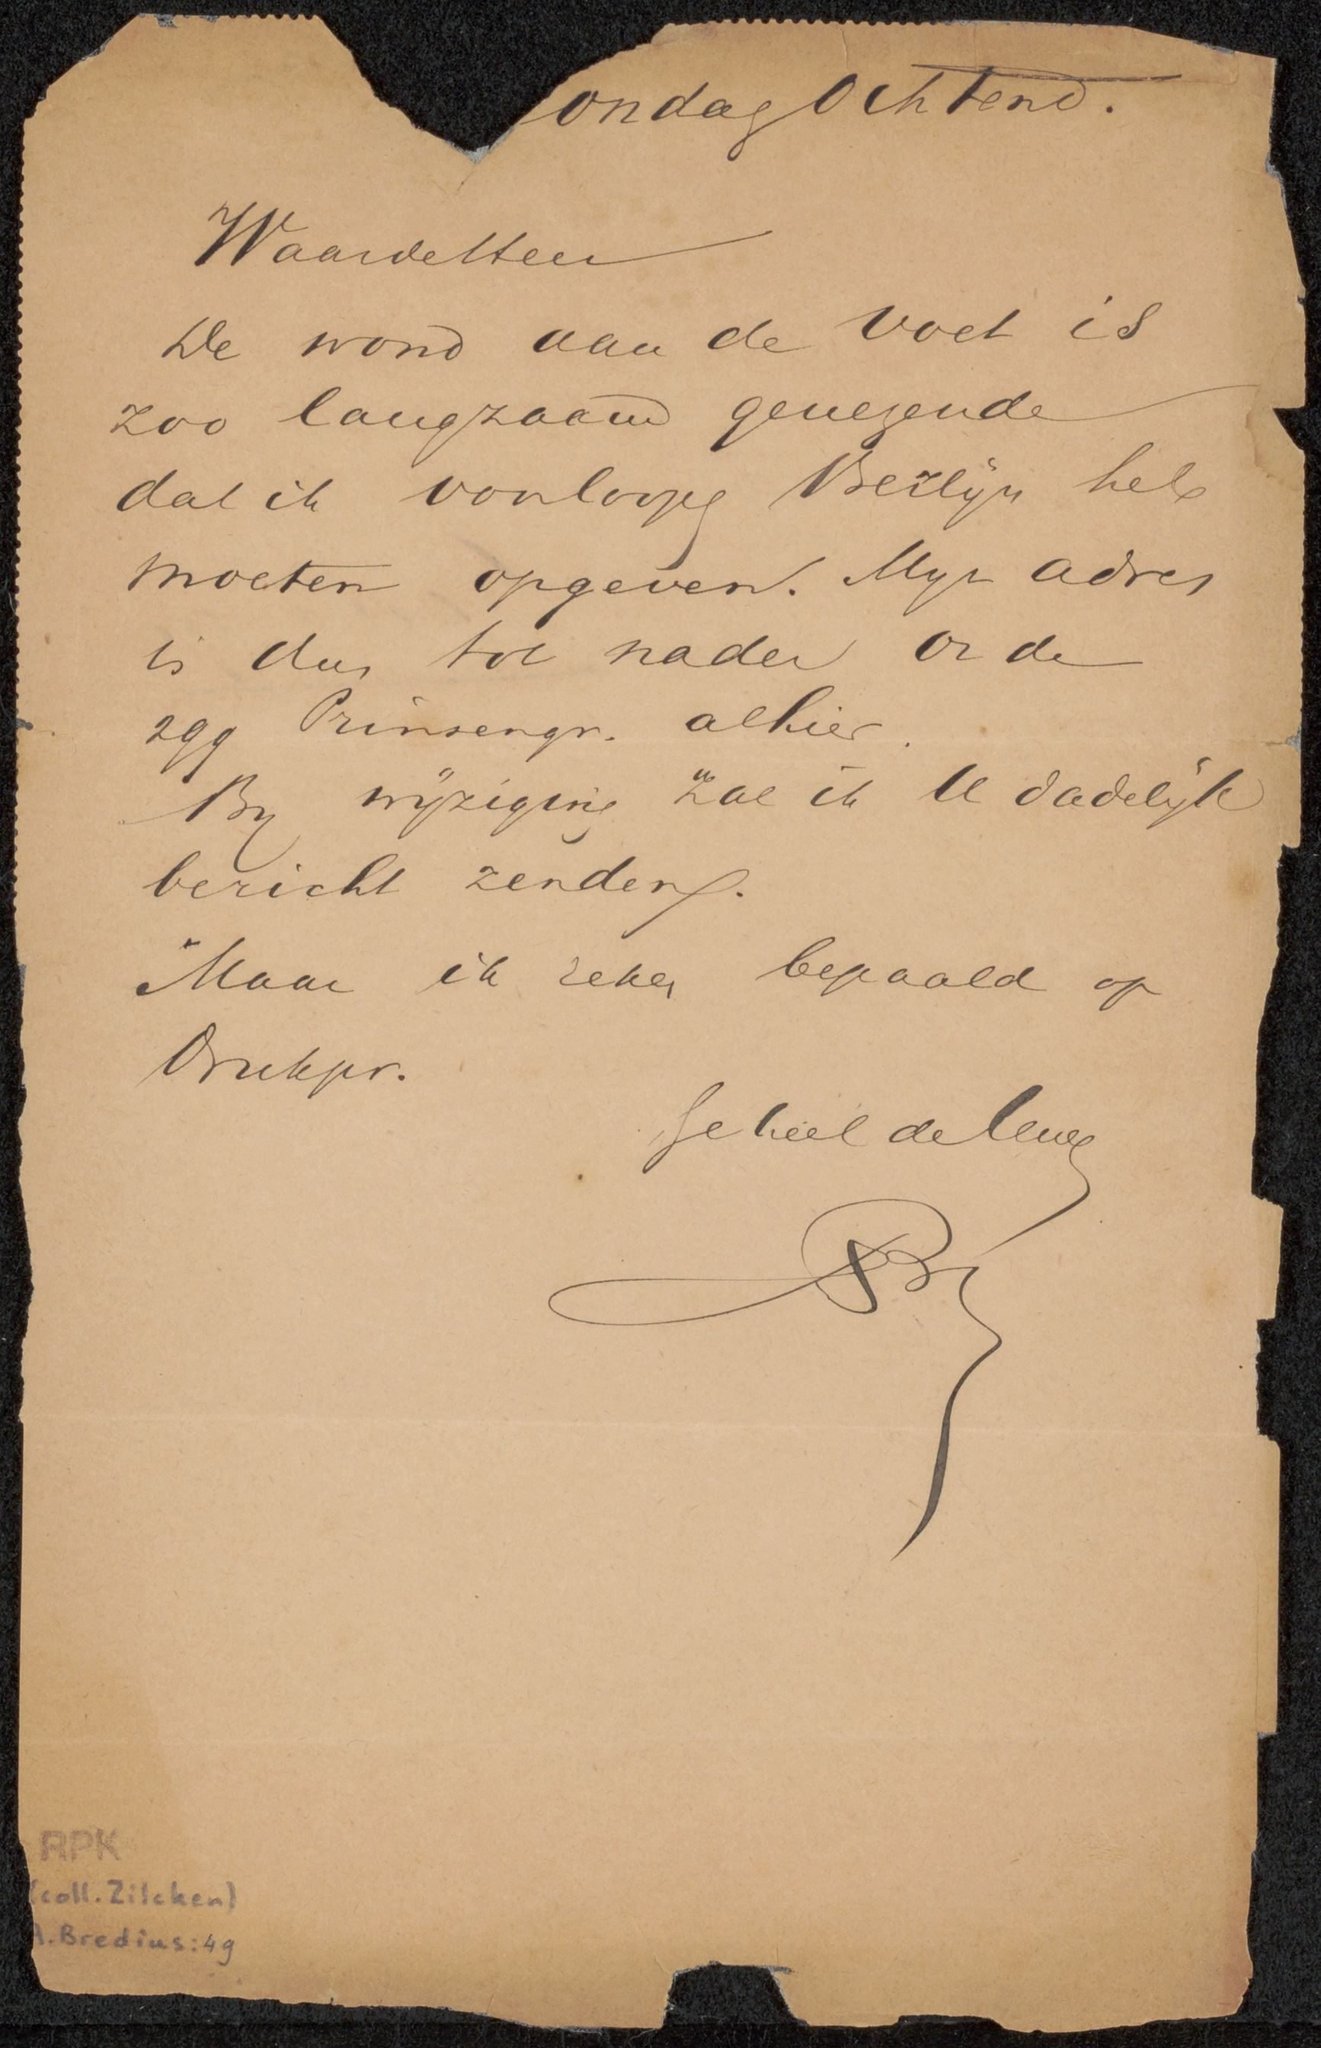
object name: letter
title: Brief aan Philip Zilcken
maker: abraham bredius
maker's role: kunsthistoricus, museumdirecteur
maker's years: 1855-1946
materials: ink, paper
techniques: pen, writing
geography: amsterdam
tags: painter, draughtsman, philip zilcken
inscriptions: collector's mark: ‘RPK’